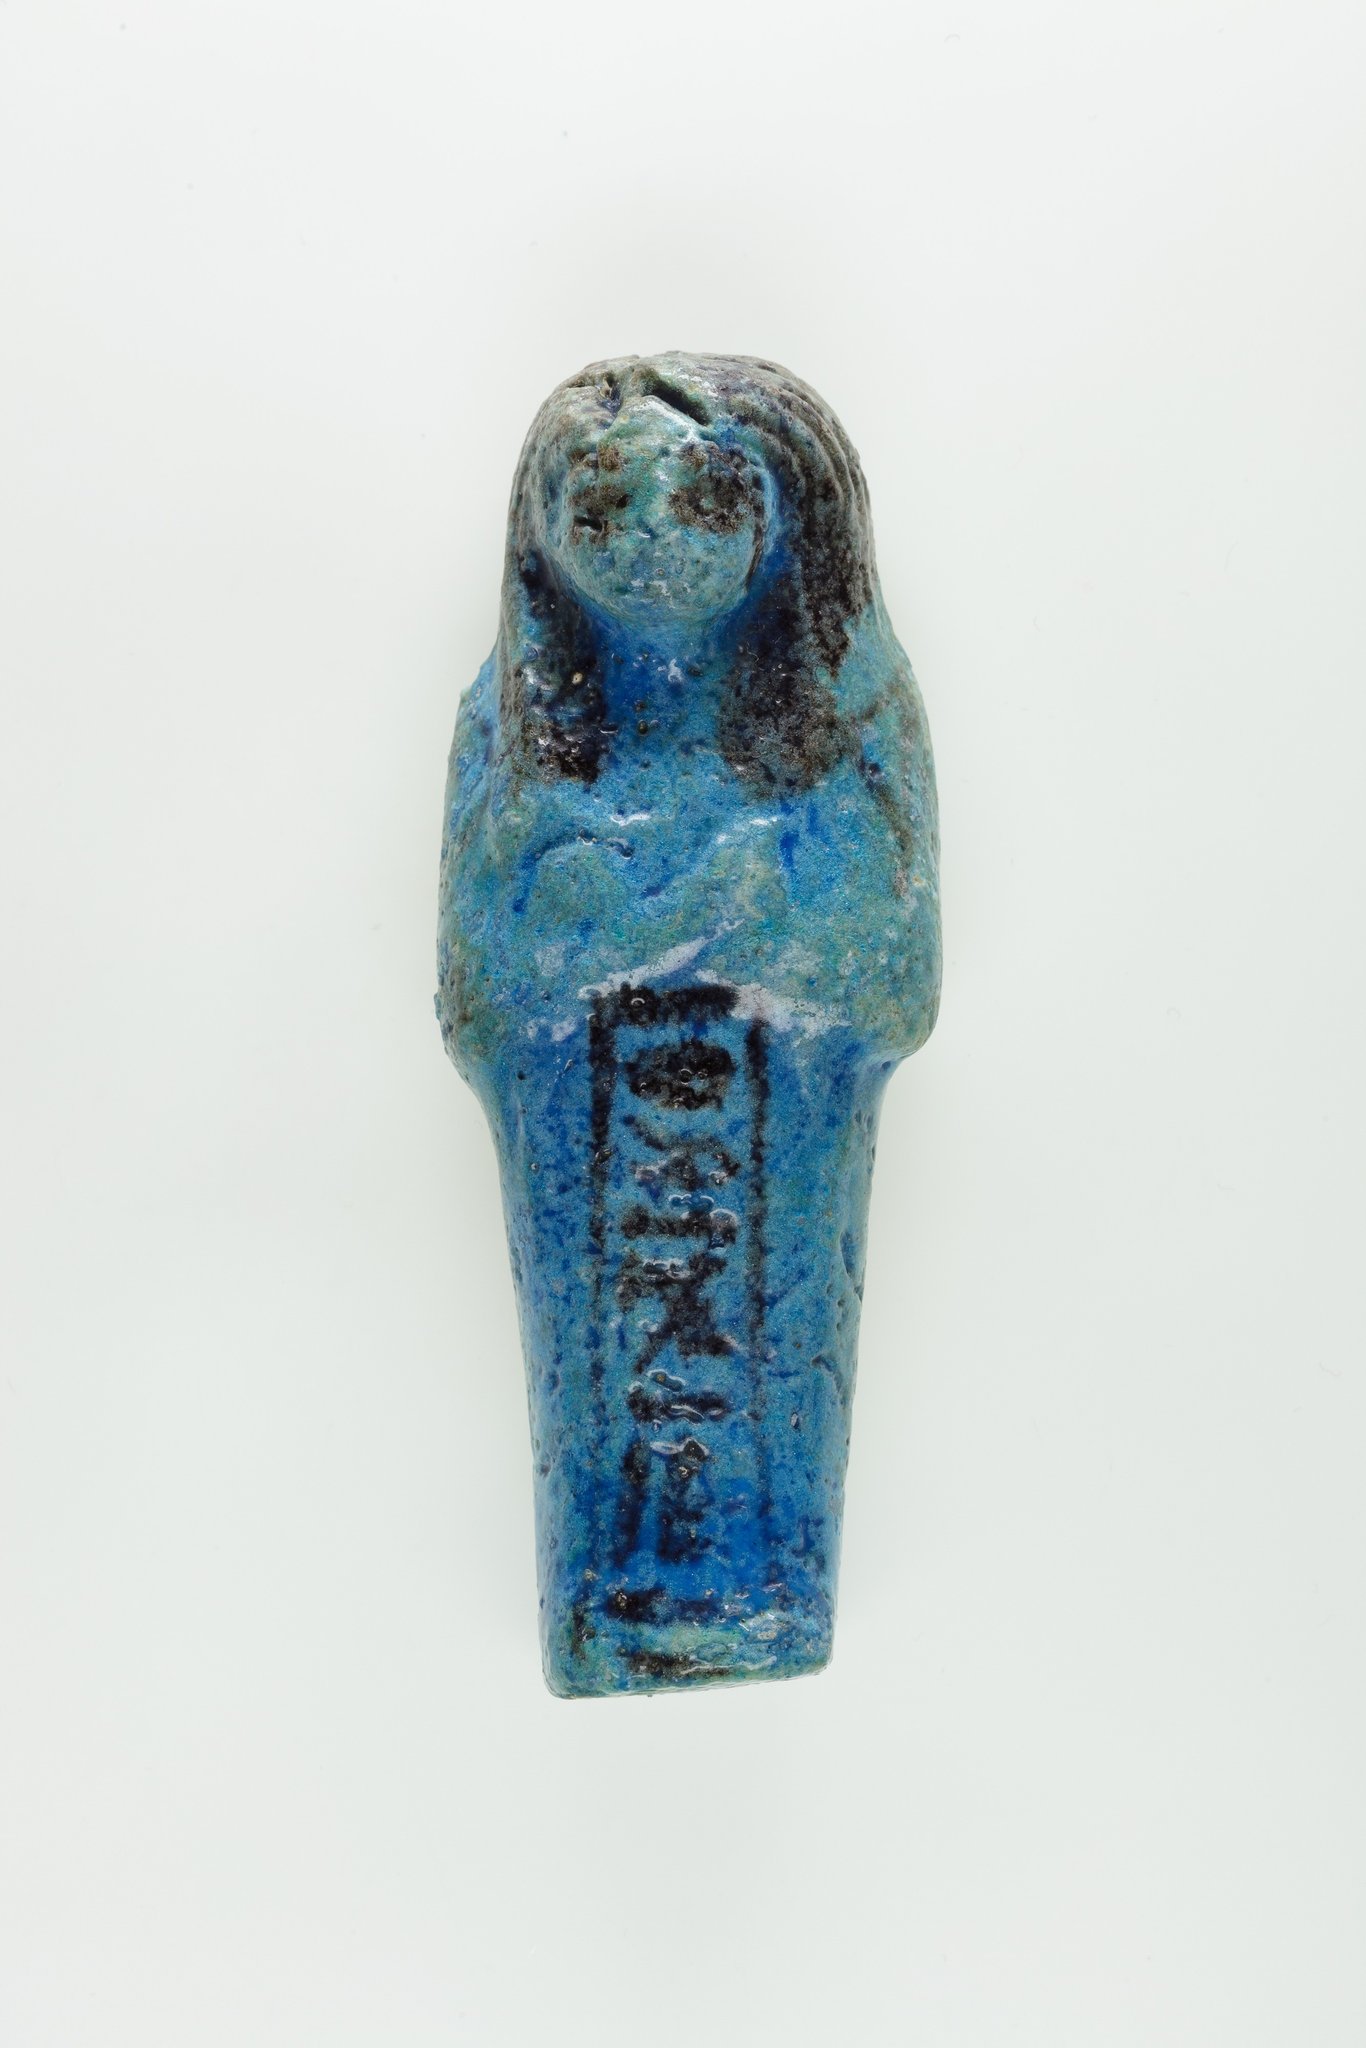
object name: shabti, worker, nauny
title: Worker Shabti of Nauny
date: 1050 BCE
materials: faience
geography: egypt